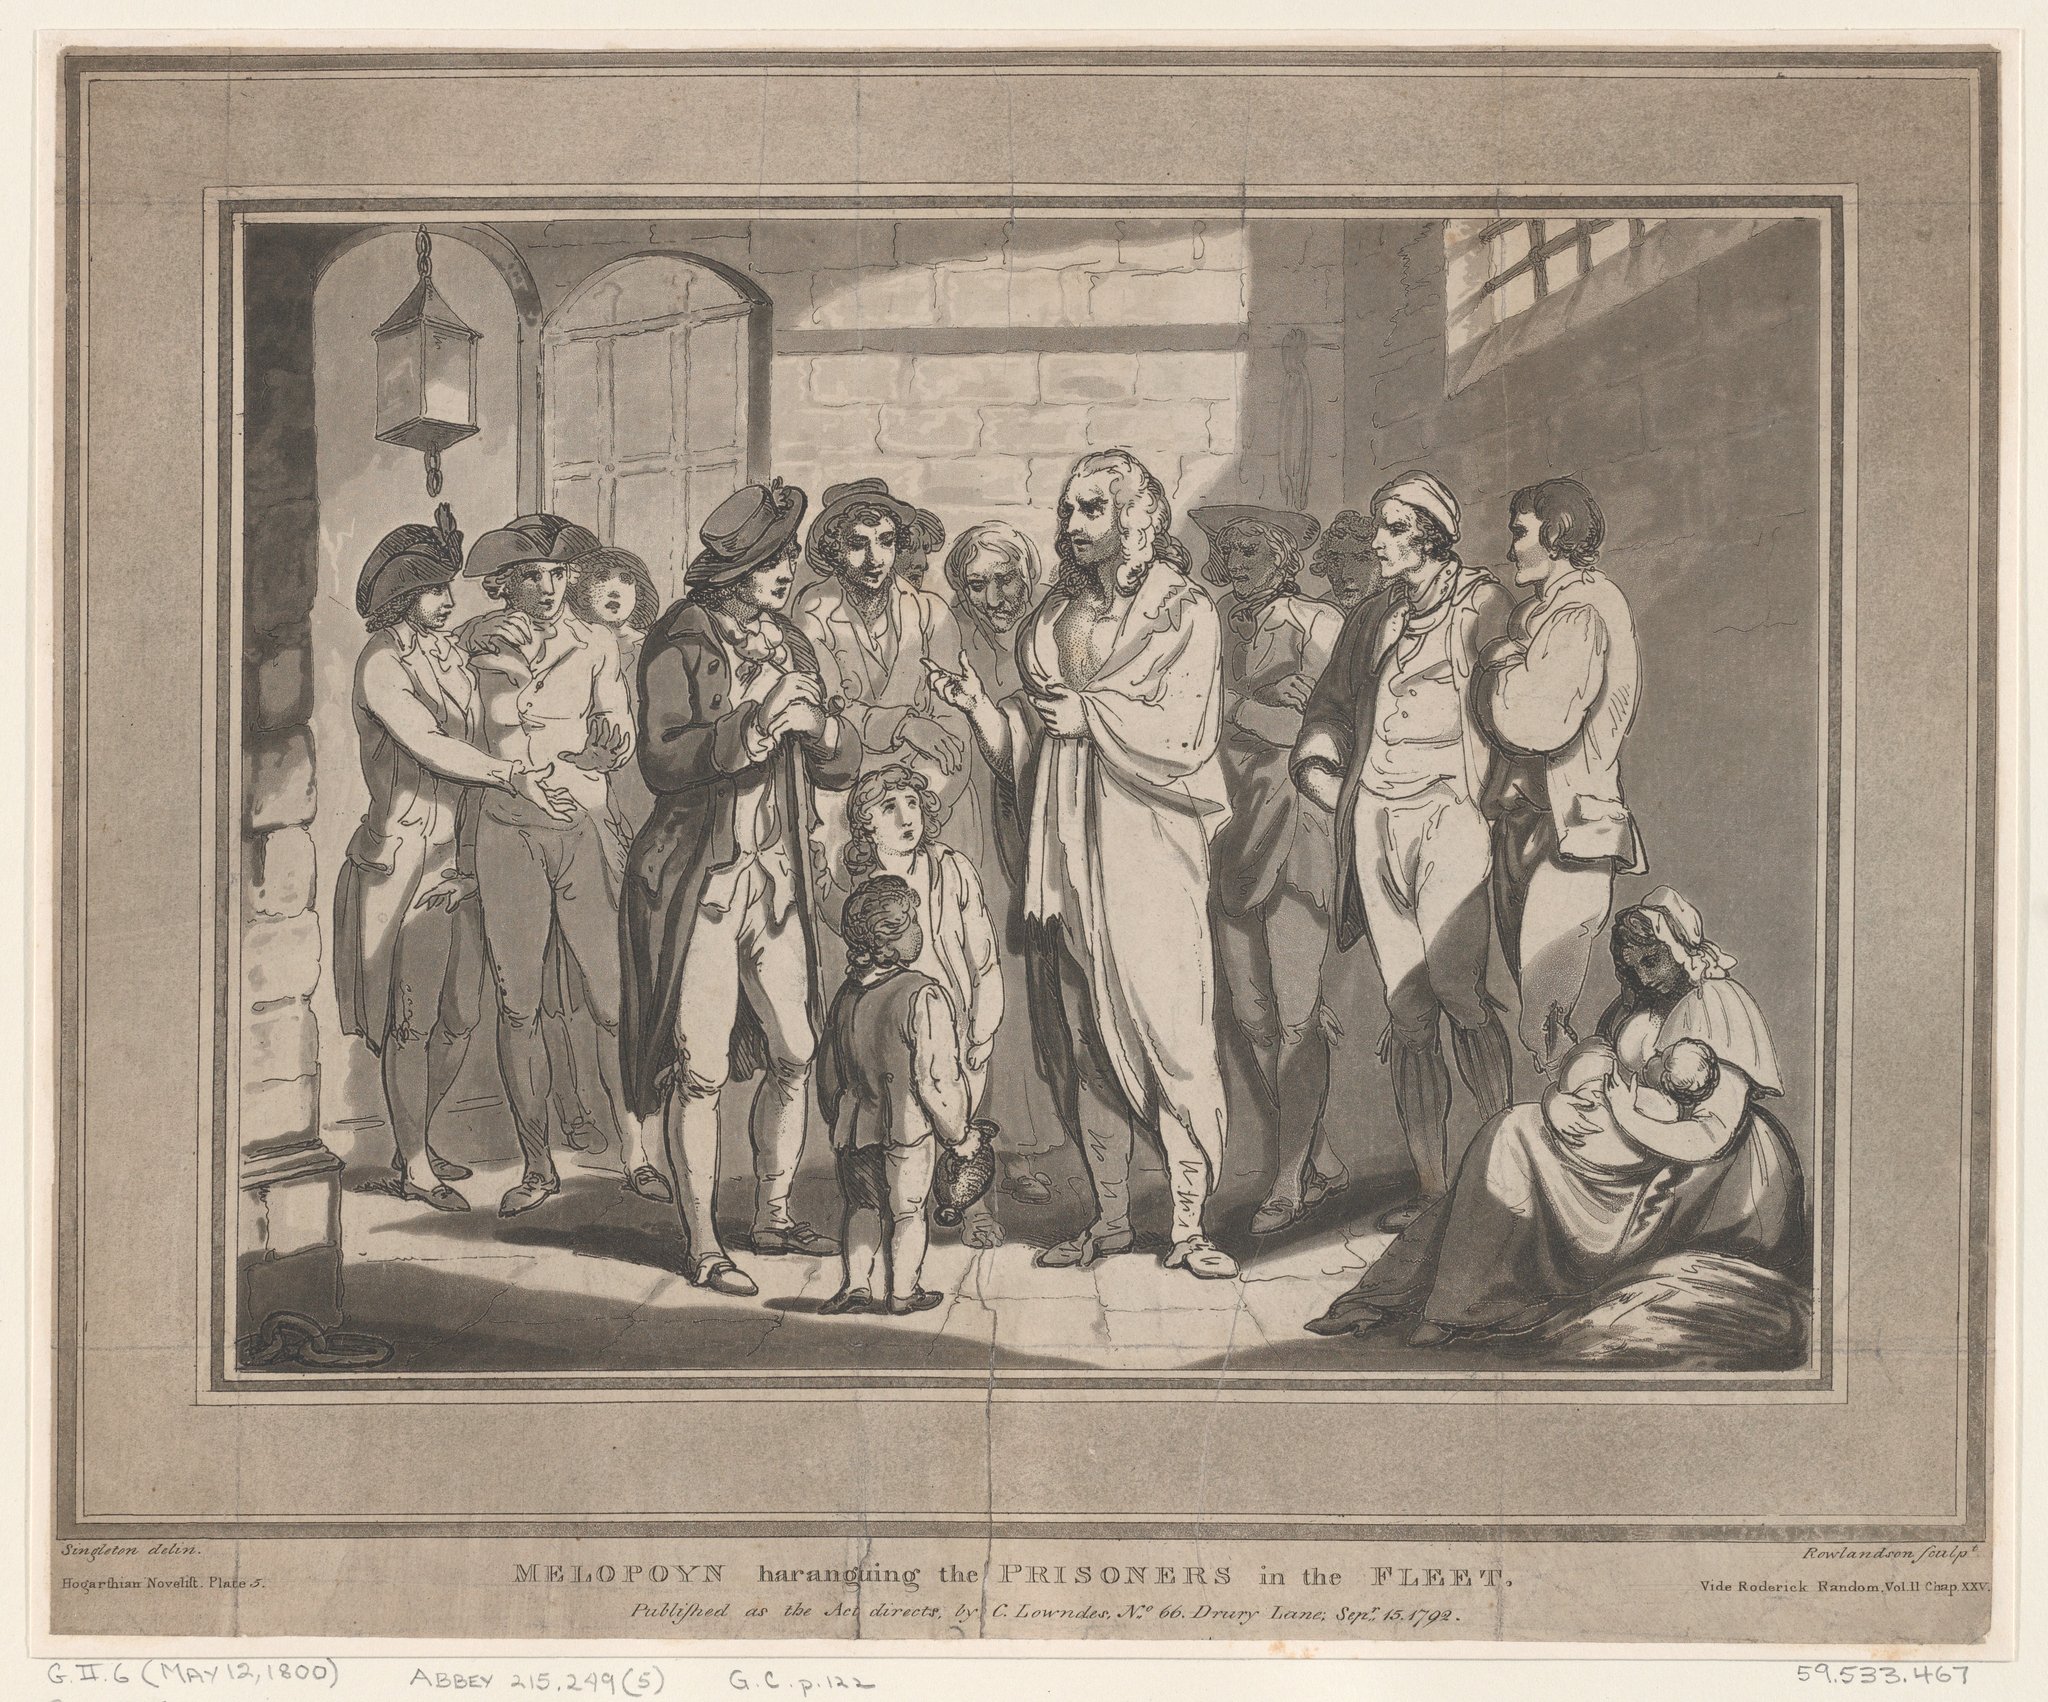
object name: print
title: Melopoyn haranguing the Prisoners in the Fleet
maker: thomas rowlandson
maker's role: artist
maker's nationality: british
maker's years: 1757-1827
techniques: aquatint, etching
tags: men